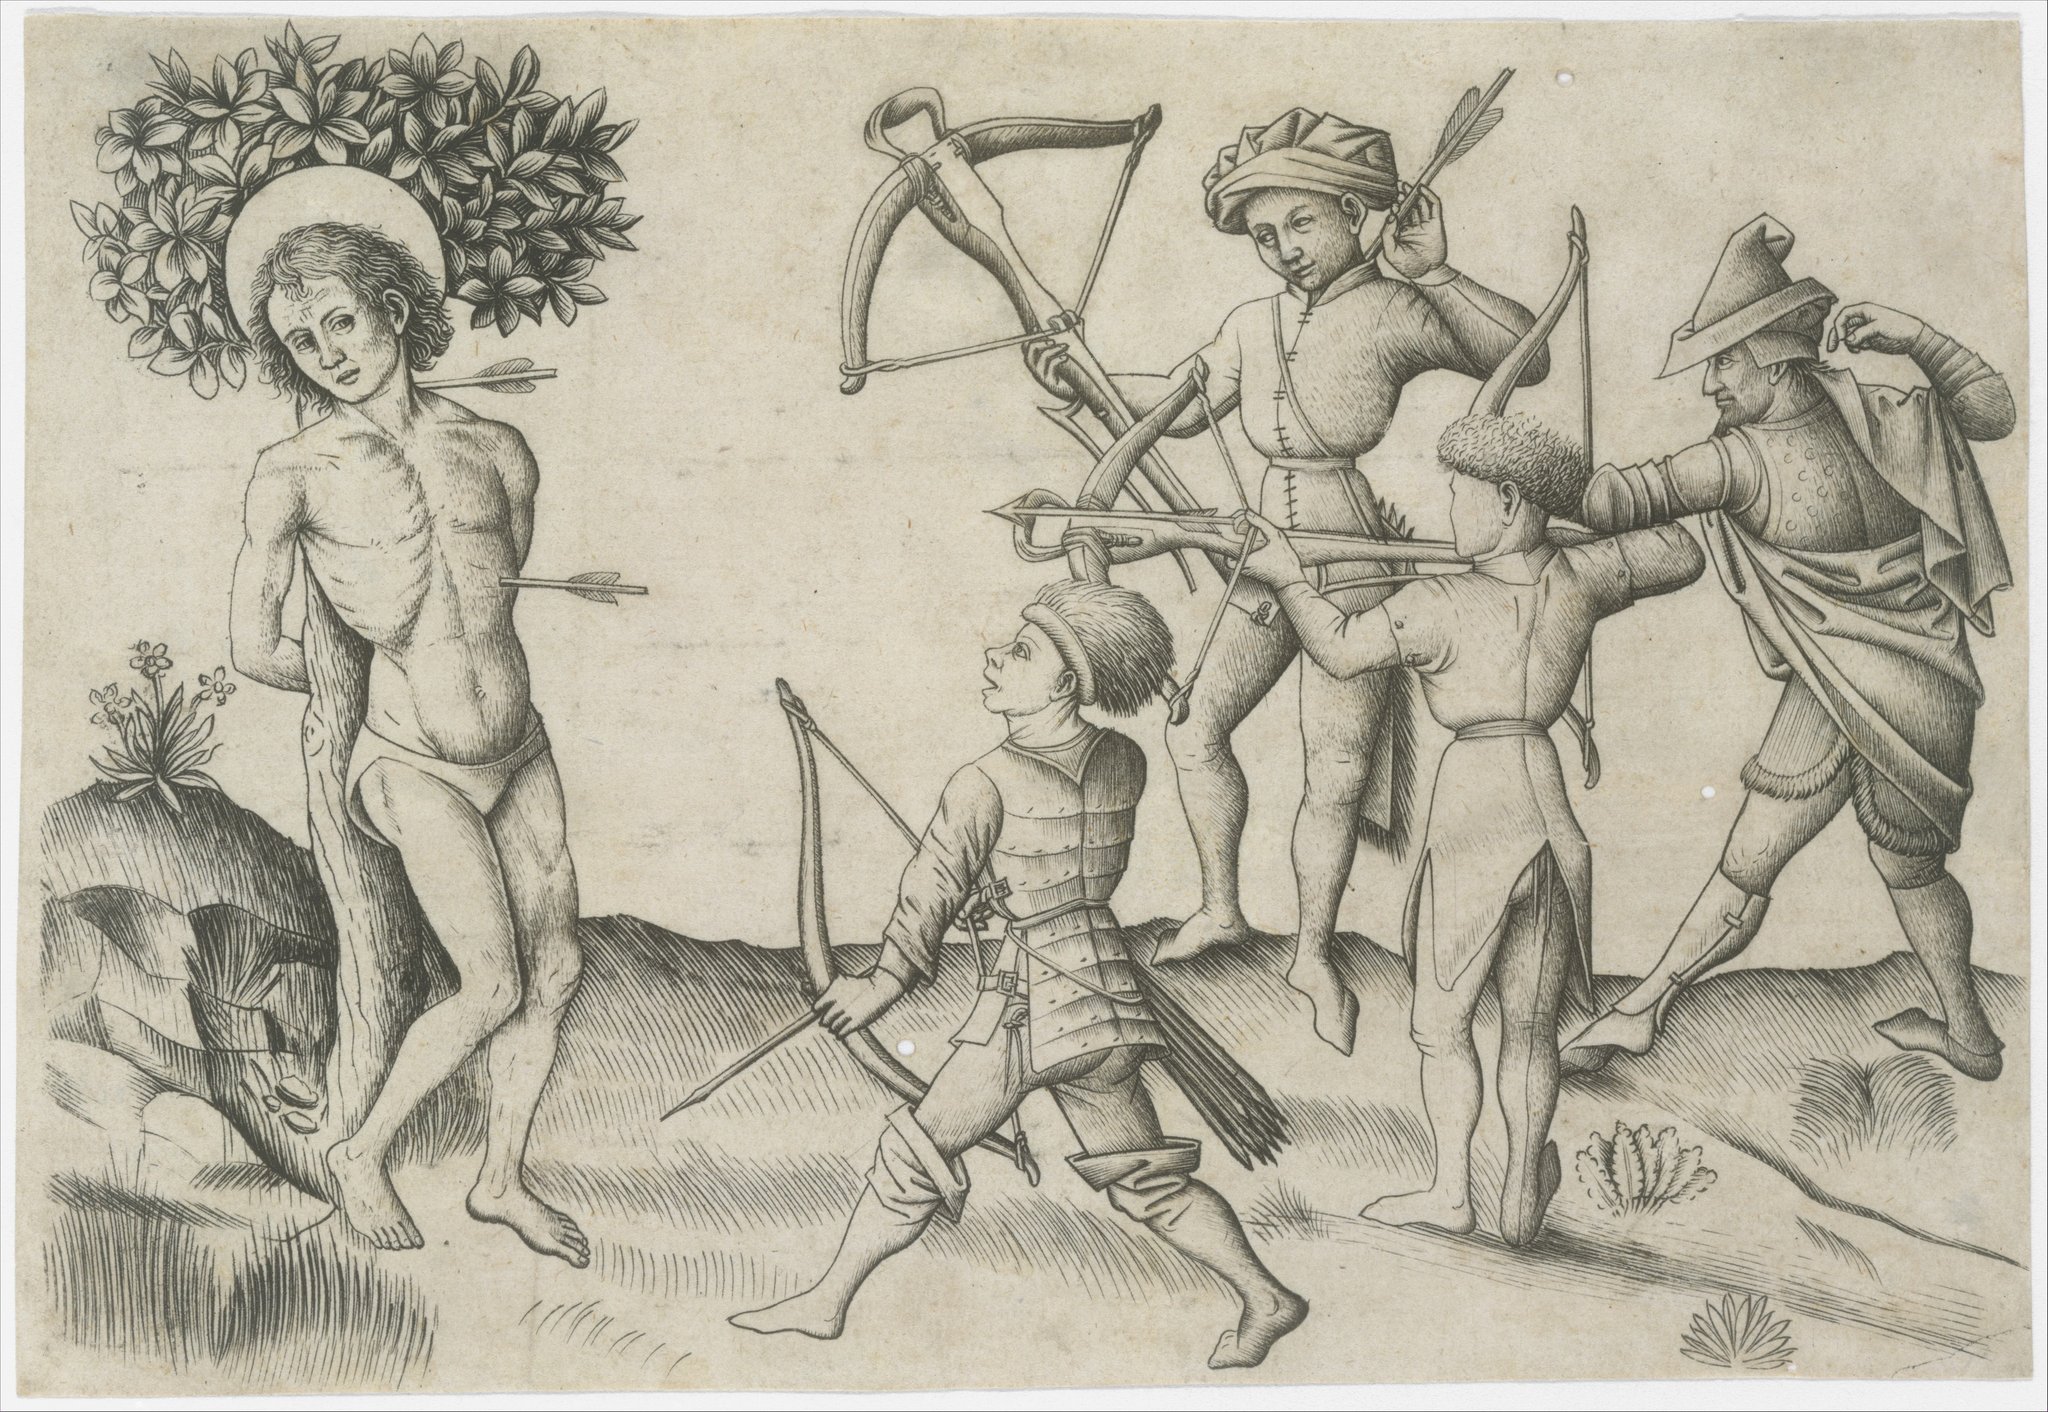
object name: print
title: Saint Sebastian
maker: master of the playing cards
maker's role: artist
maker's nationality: german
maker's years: 1425-1450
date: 1401-1500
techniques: engraving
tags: soldiers,bow and arrow,men,trees,saints